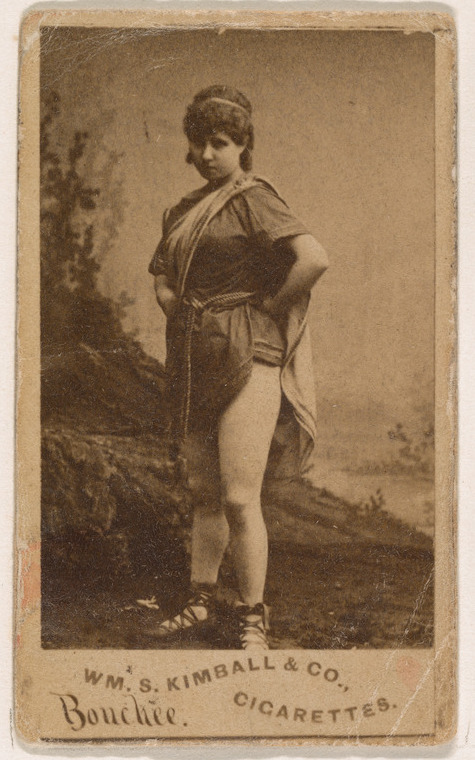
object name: photograph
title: Miss Bouchee, from the Actresses series (N203) issued by Wm. S. Kimball & Co.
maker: william s. kimball & company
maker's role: publisher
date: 1889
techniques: color lithograph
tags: portraits,women,actresses